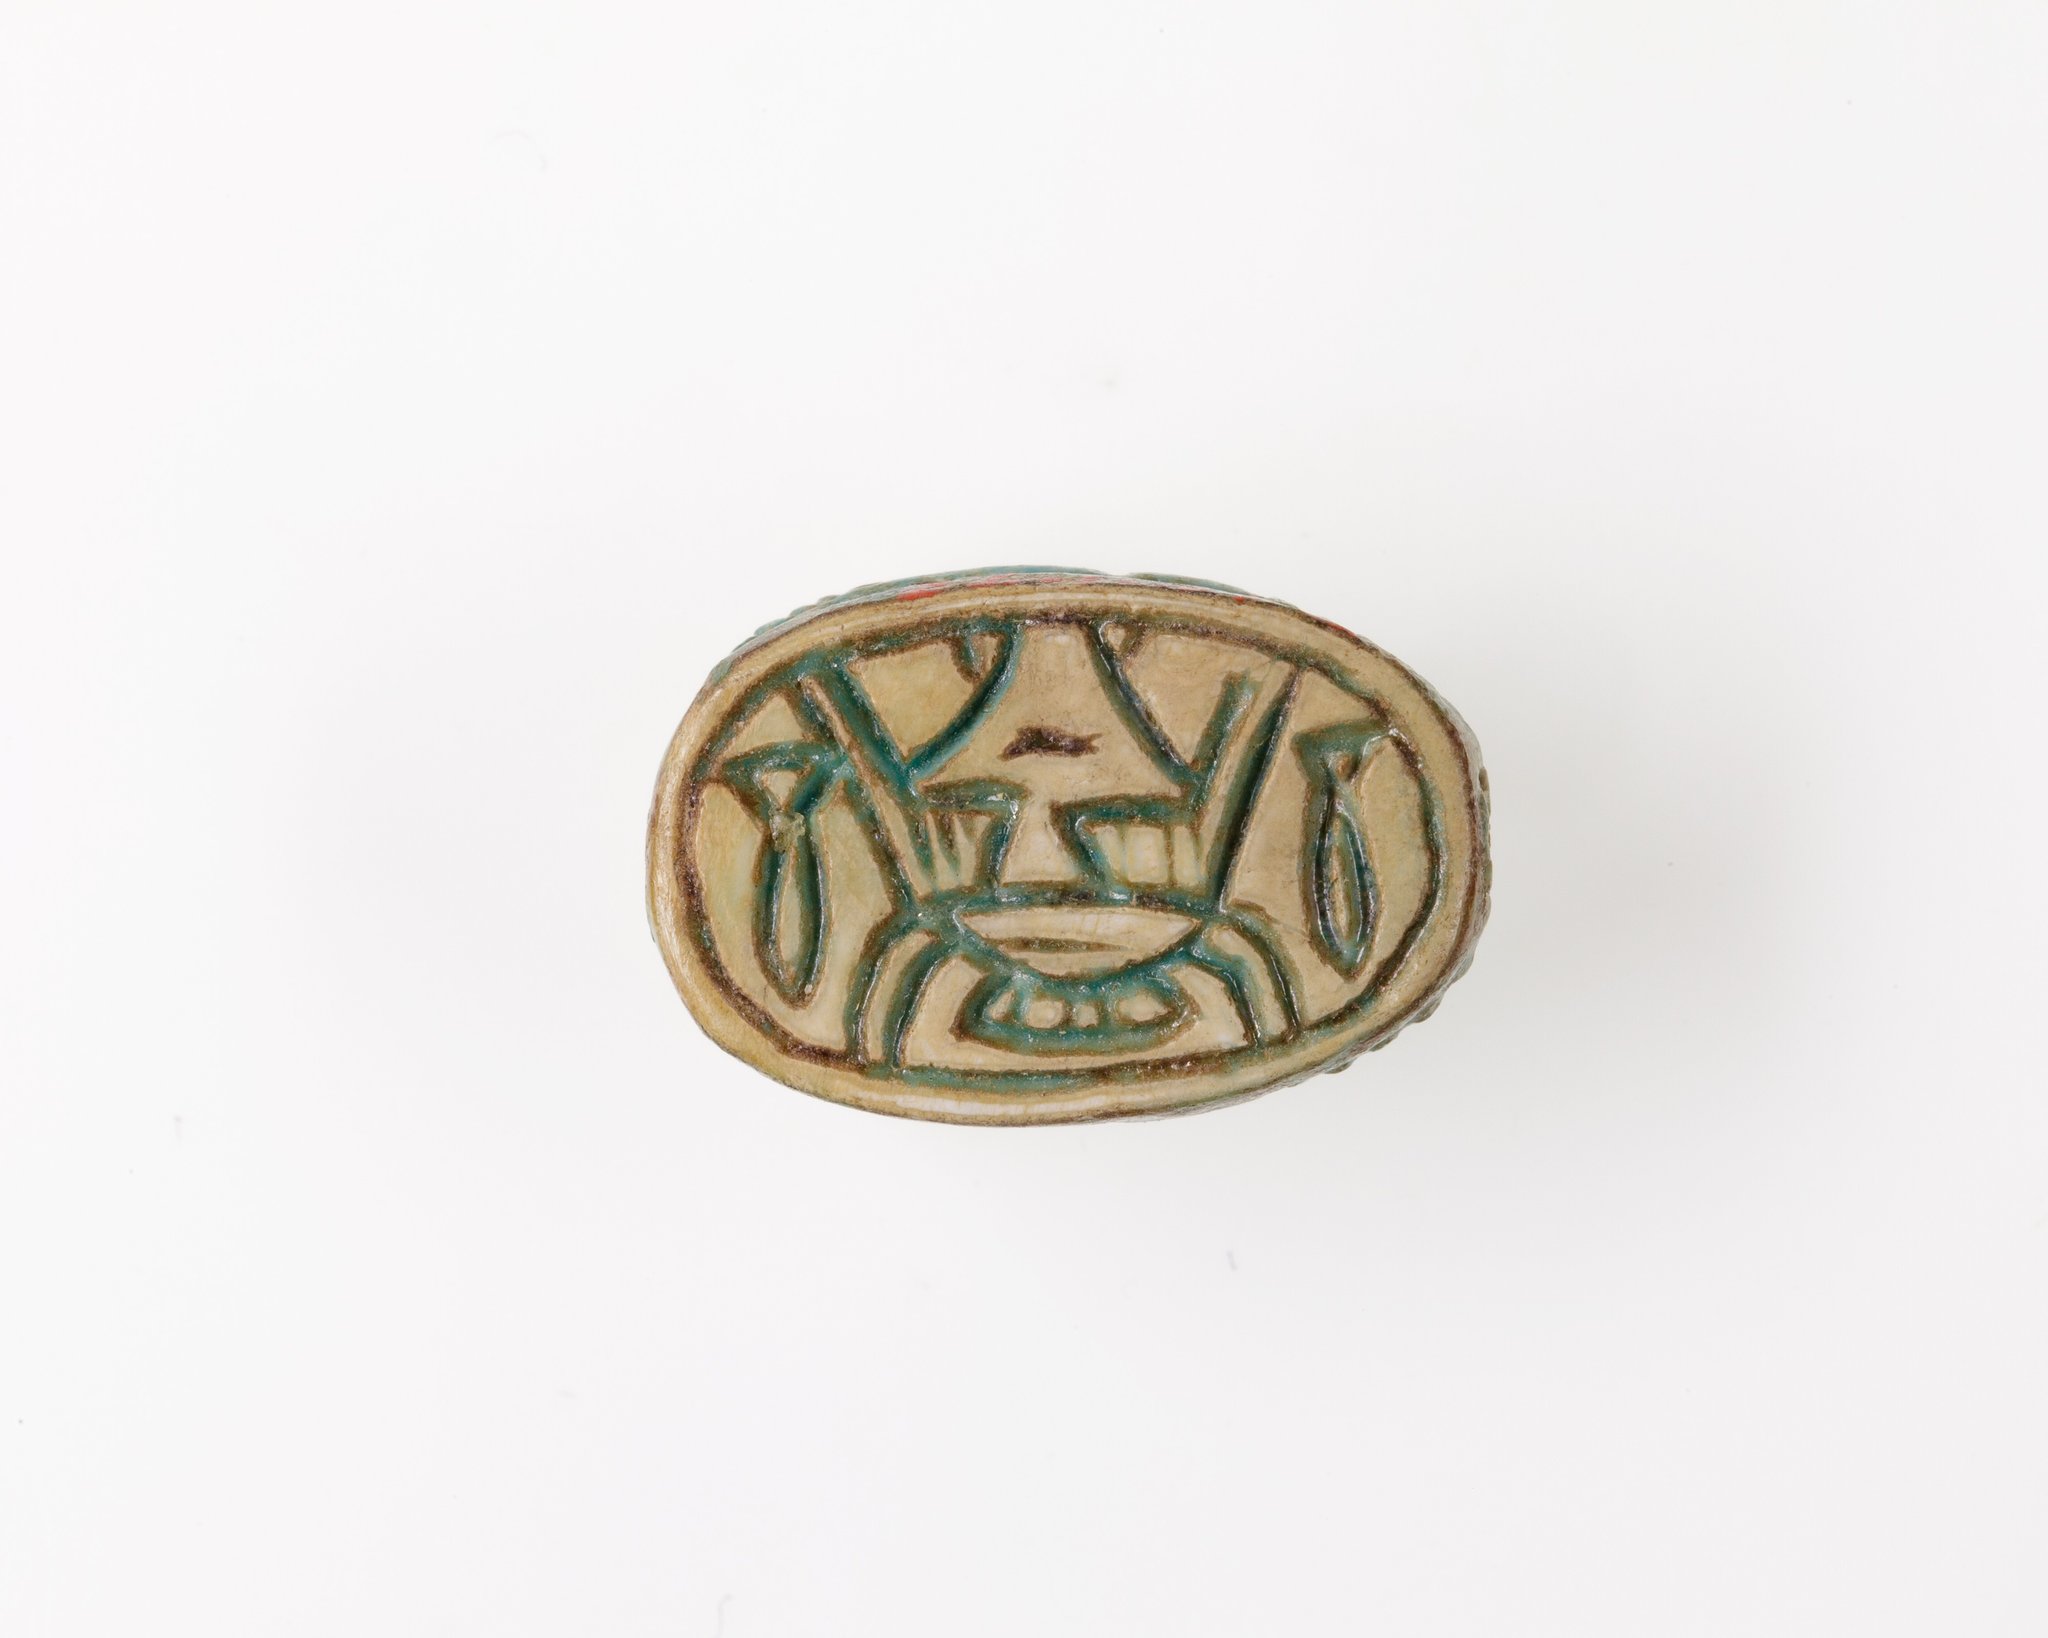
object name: scarab, hieroglyph, nub gold, red crown, wadj papyrus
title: Scarab Inscribed with Hieroglyphs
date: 1740-1640 BCE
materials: stone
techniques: glazing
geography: egypt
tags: scarabs